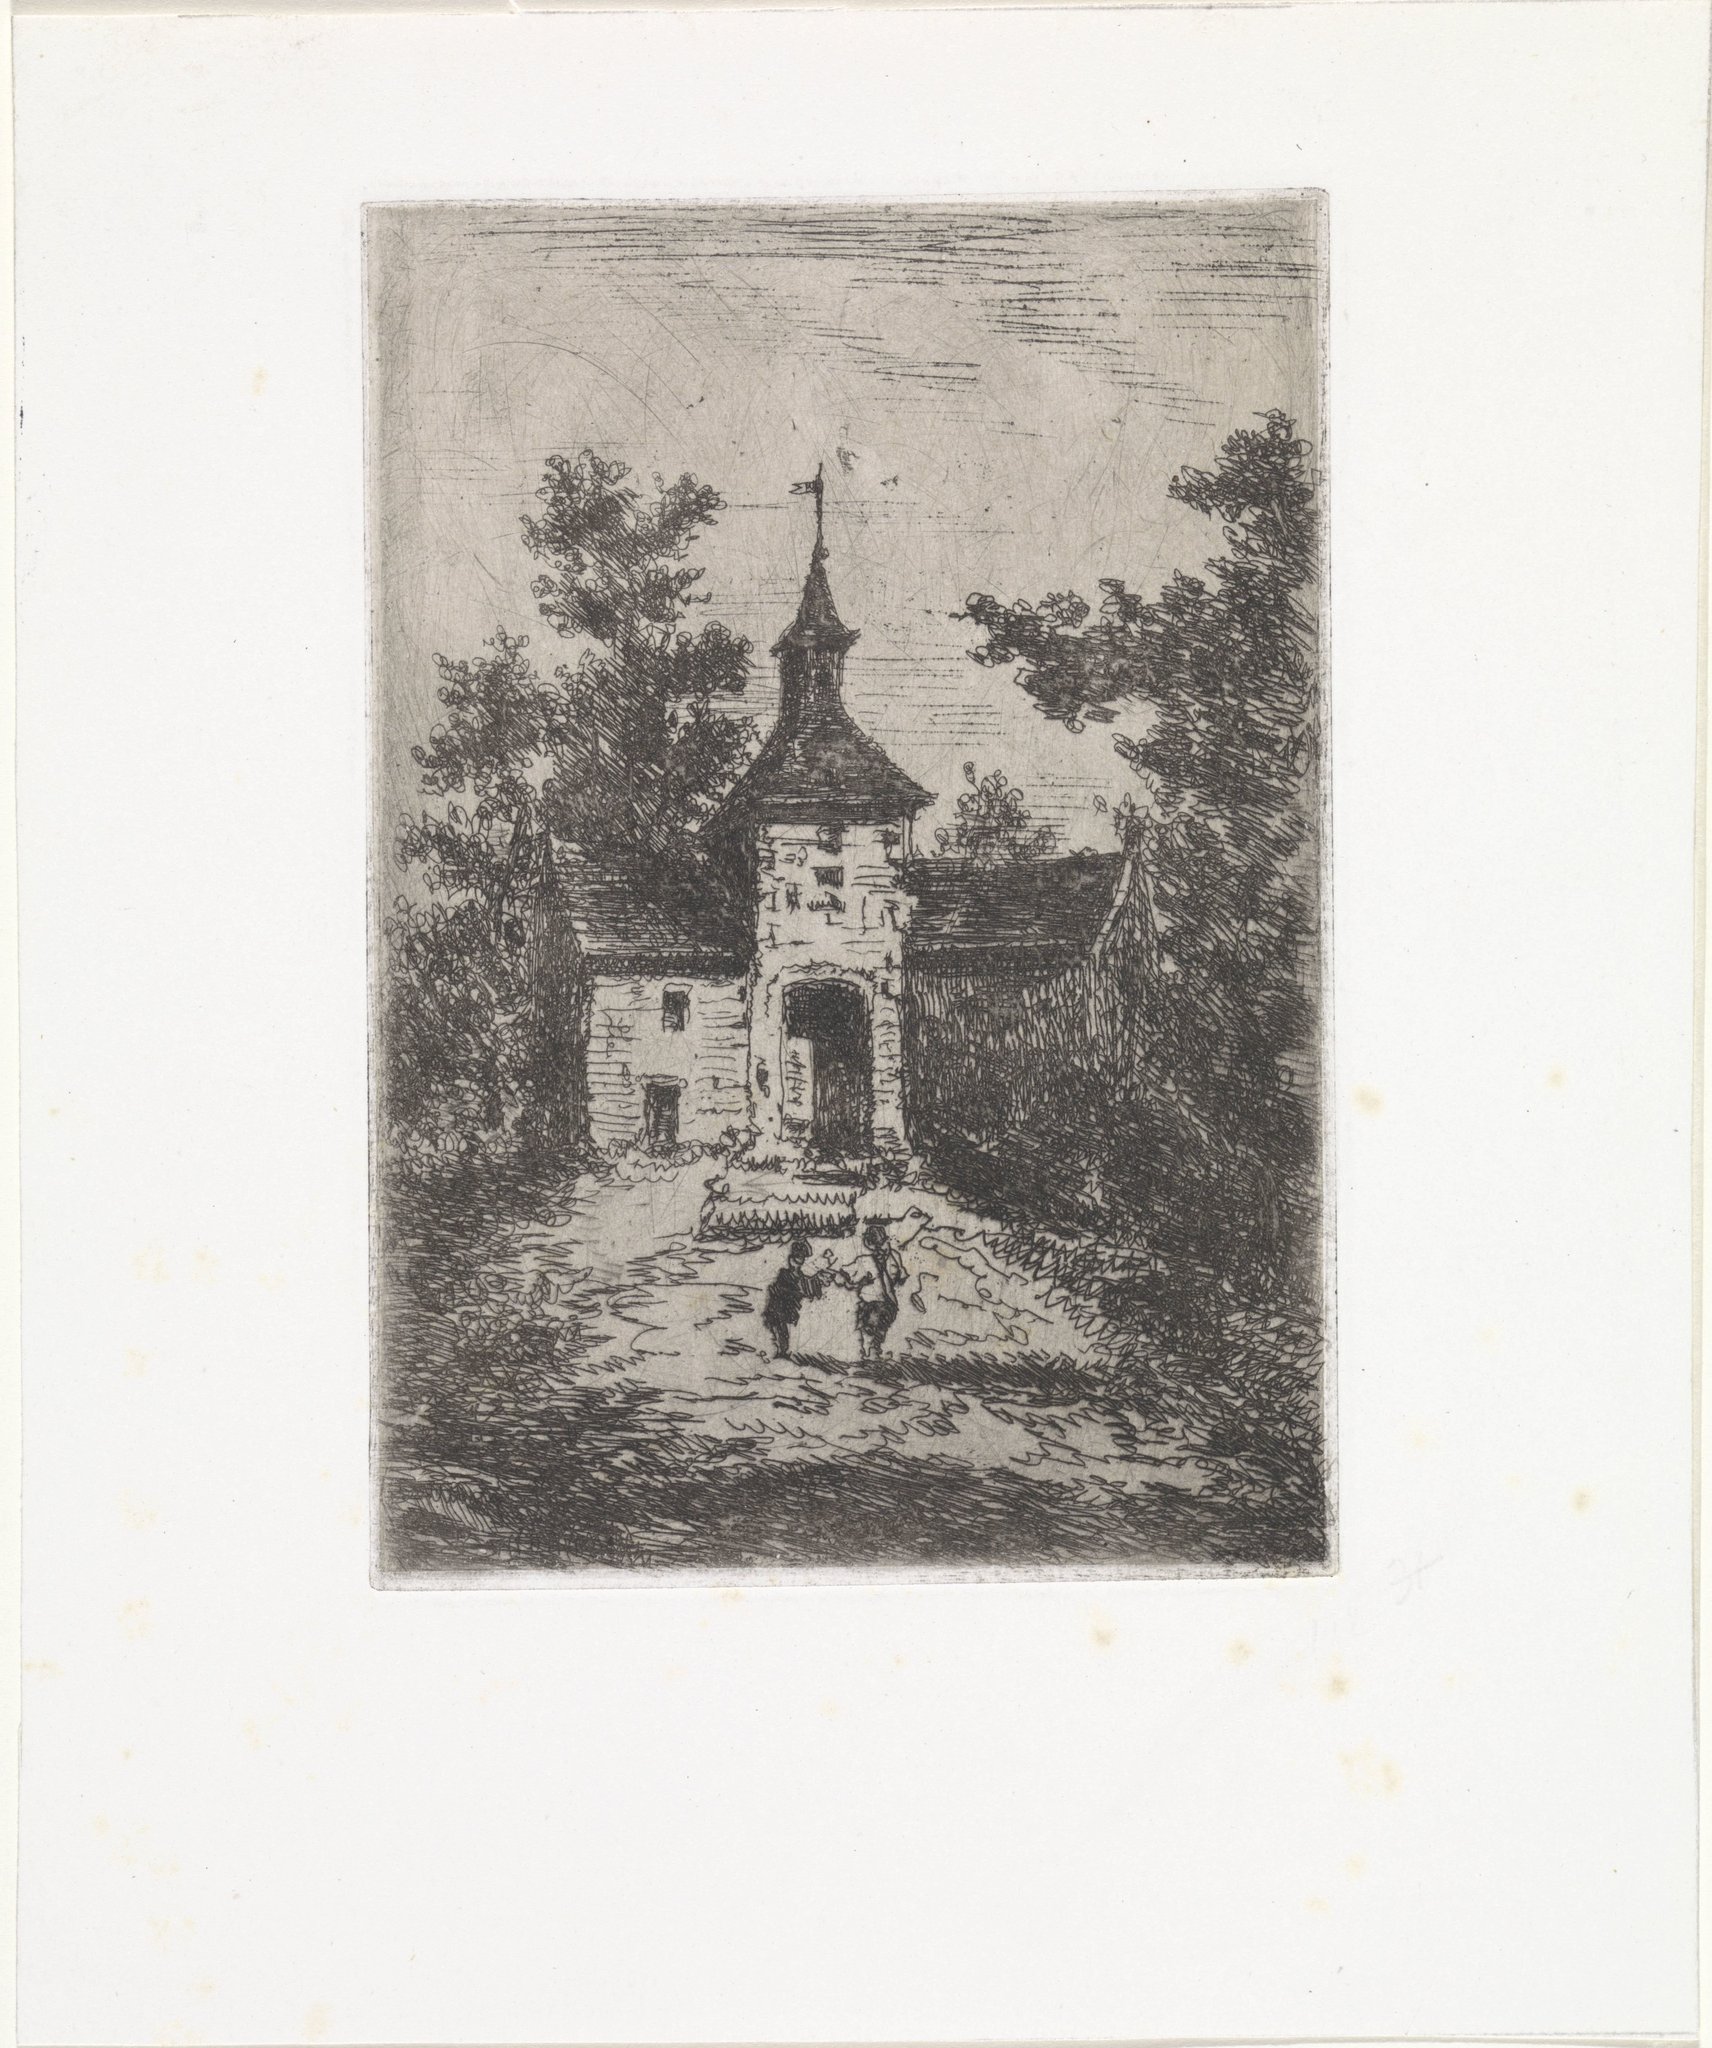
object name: print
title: Ingang van een klein kasteel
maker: arnoud schaepkens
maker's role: print maker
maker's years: 1816-1904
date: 1855-1904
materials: paper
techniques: drypoint, etching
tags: castle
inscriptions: collector's mark: Lugt 2228